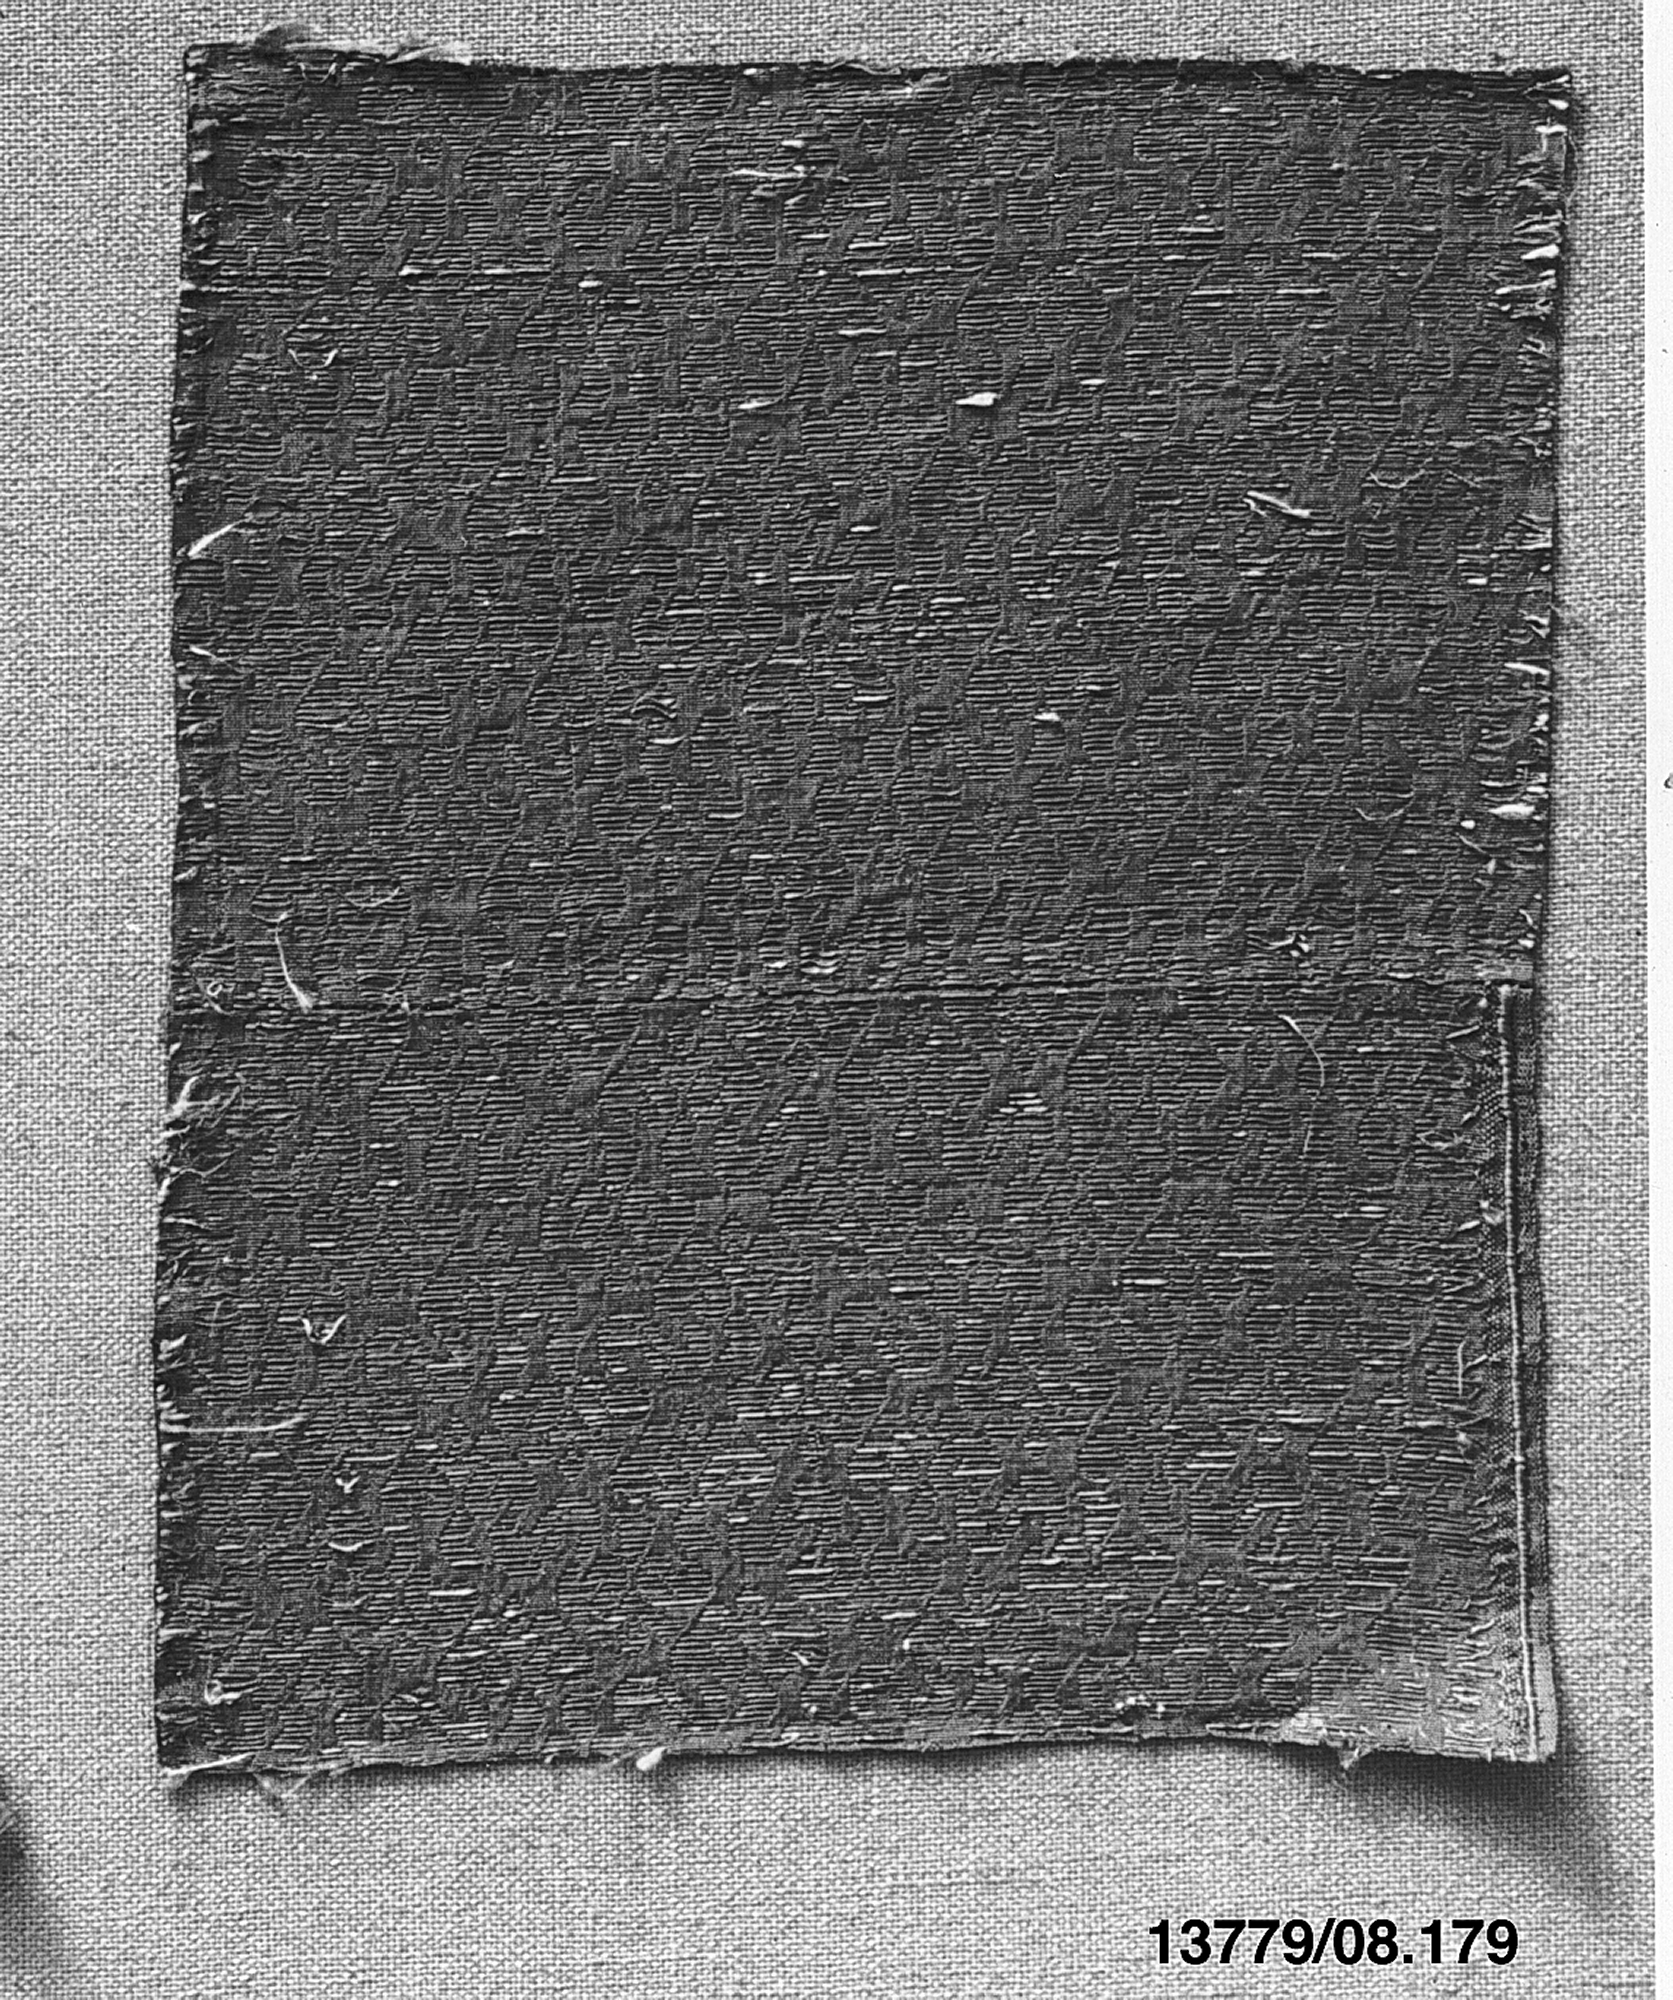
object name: piece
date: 1501-1700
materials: metal thread, silk